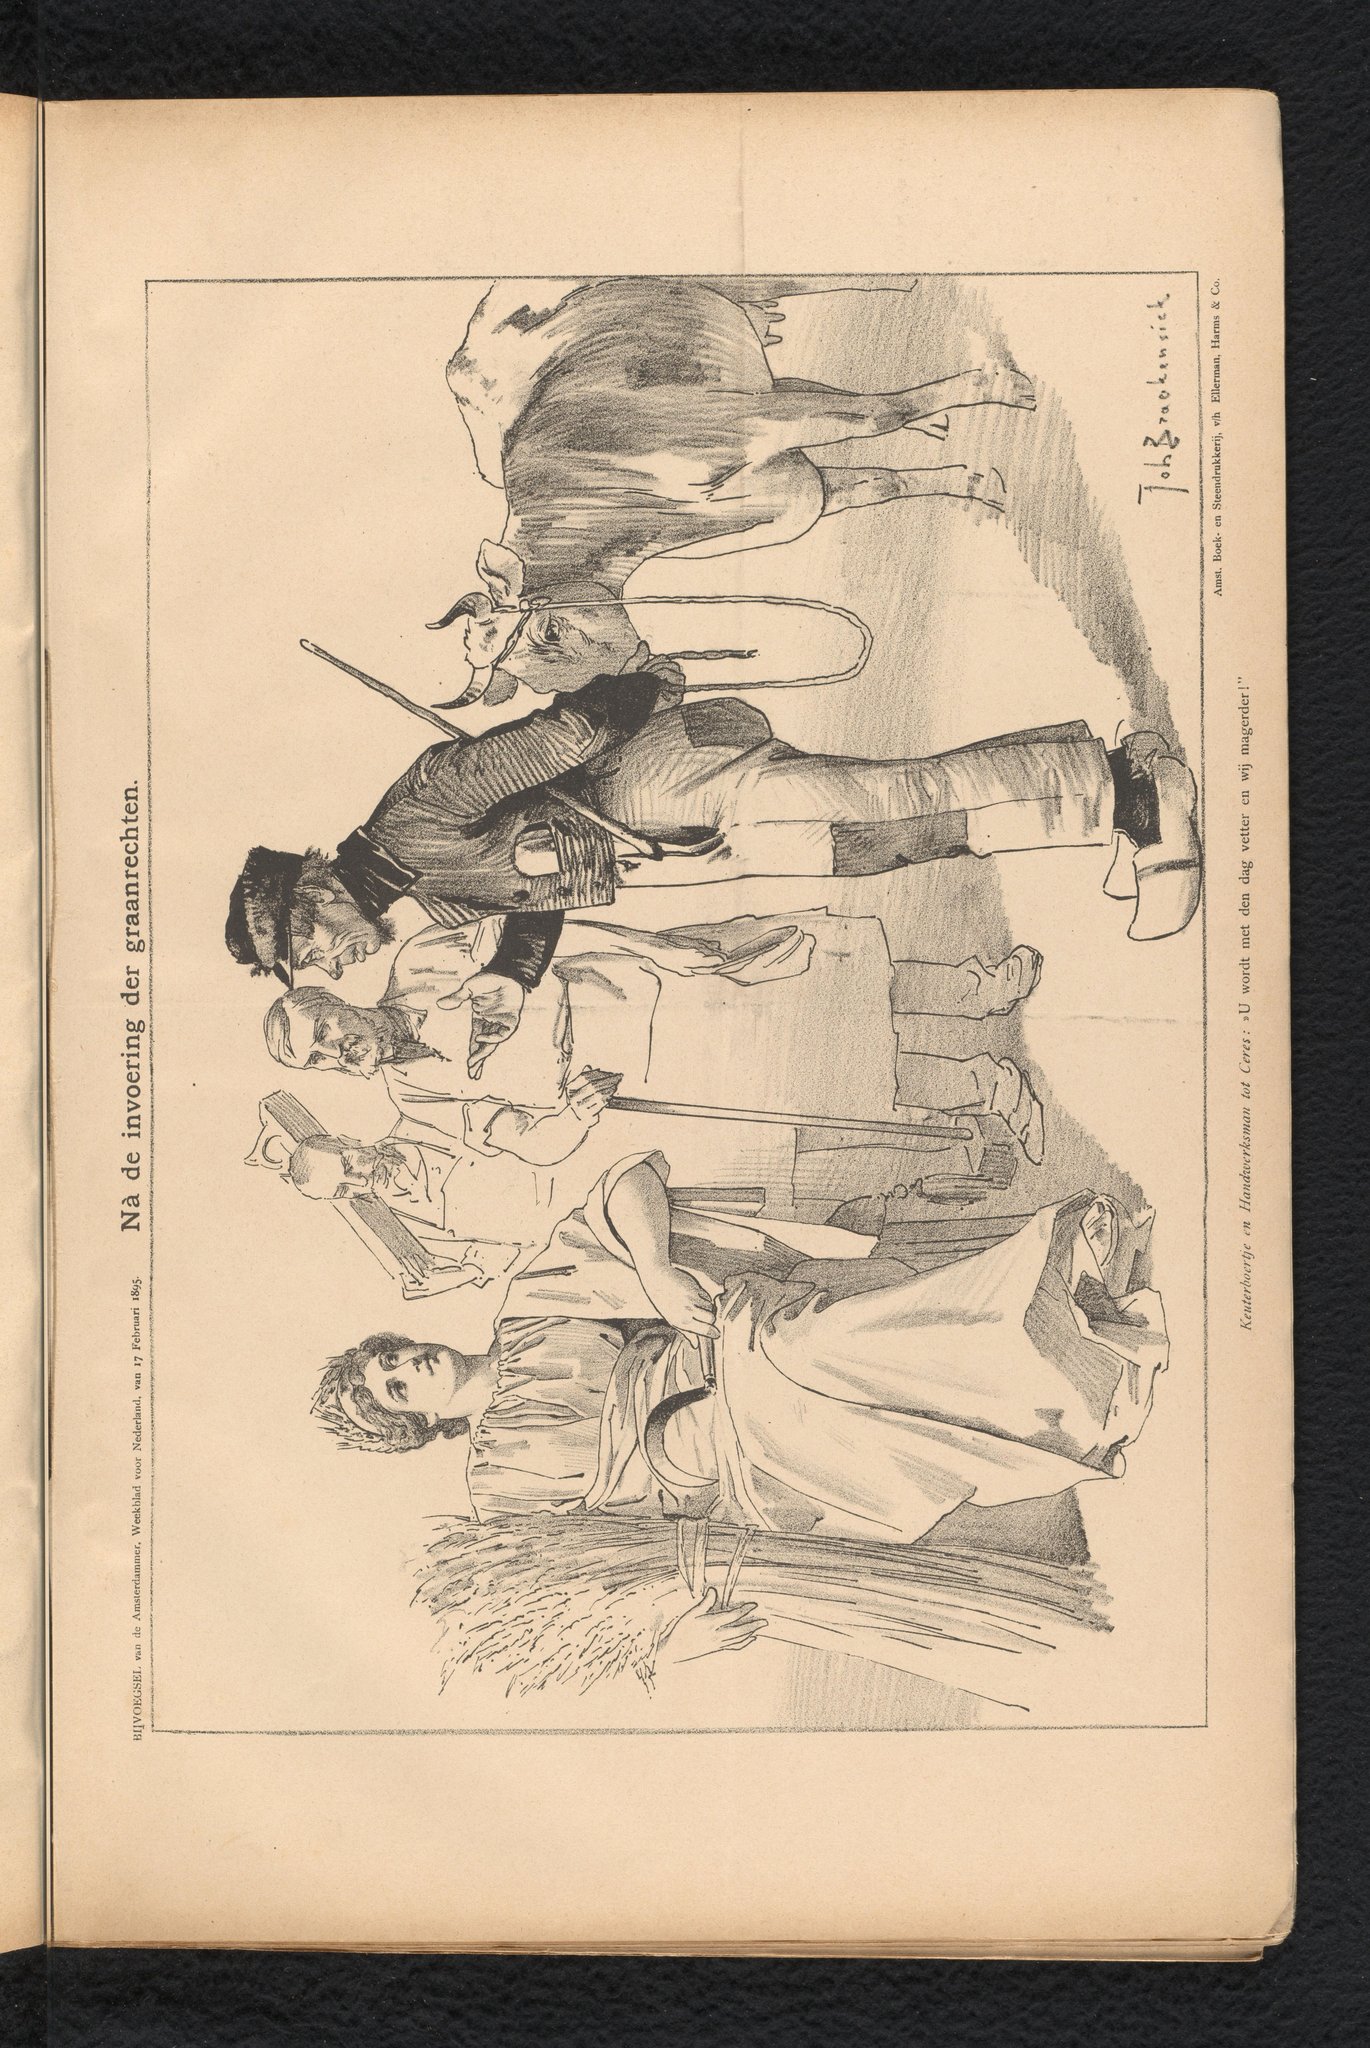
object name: cartoon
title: Nà de invoering der graanrechten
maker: johan braakensiek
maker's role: draughtsman, print maker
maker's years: 1858-1940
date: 1895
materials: paper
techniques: lithograph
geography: amsterdam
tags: farmers, contrast between rich and poor, political caricatures and satires, ceres, patroness of agriculture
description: Een Nederlandse keuterboer en twee handwerkslieden beklagen zich over hun economische achteruitgang bij de zittende Ceres met sikkel en korenschoof.